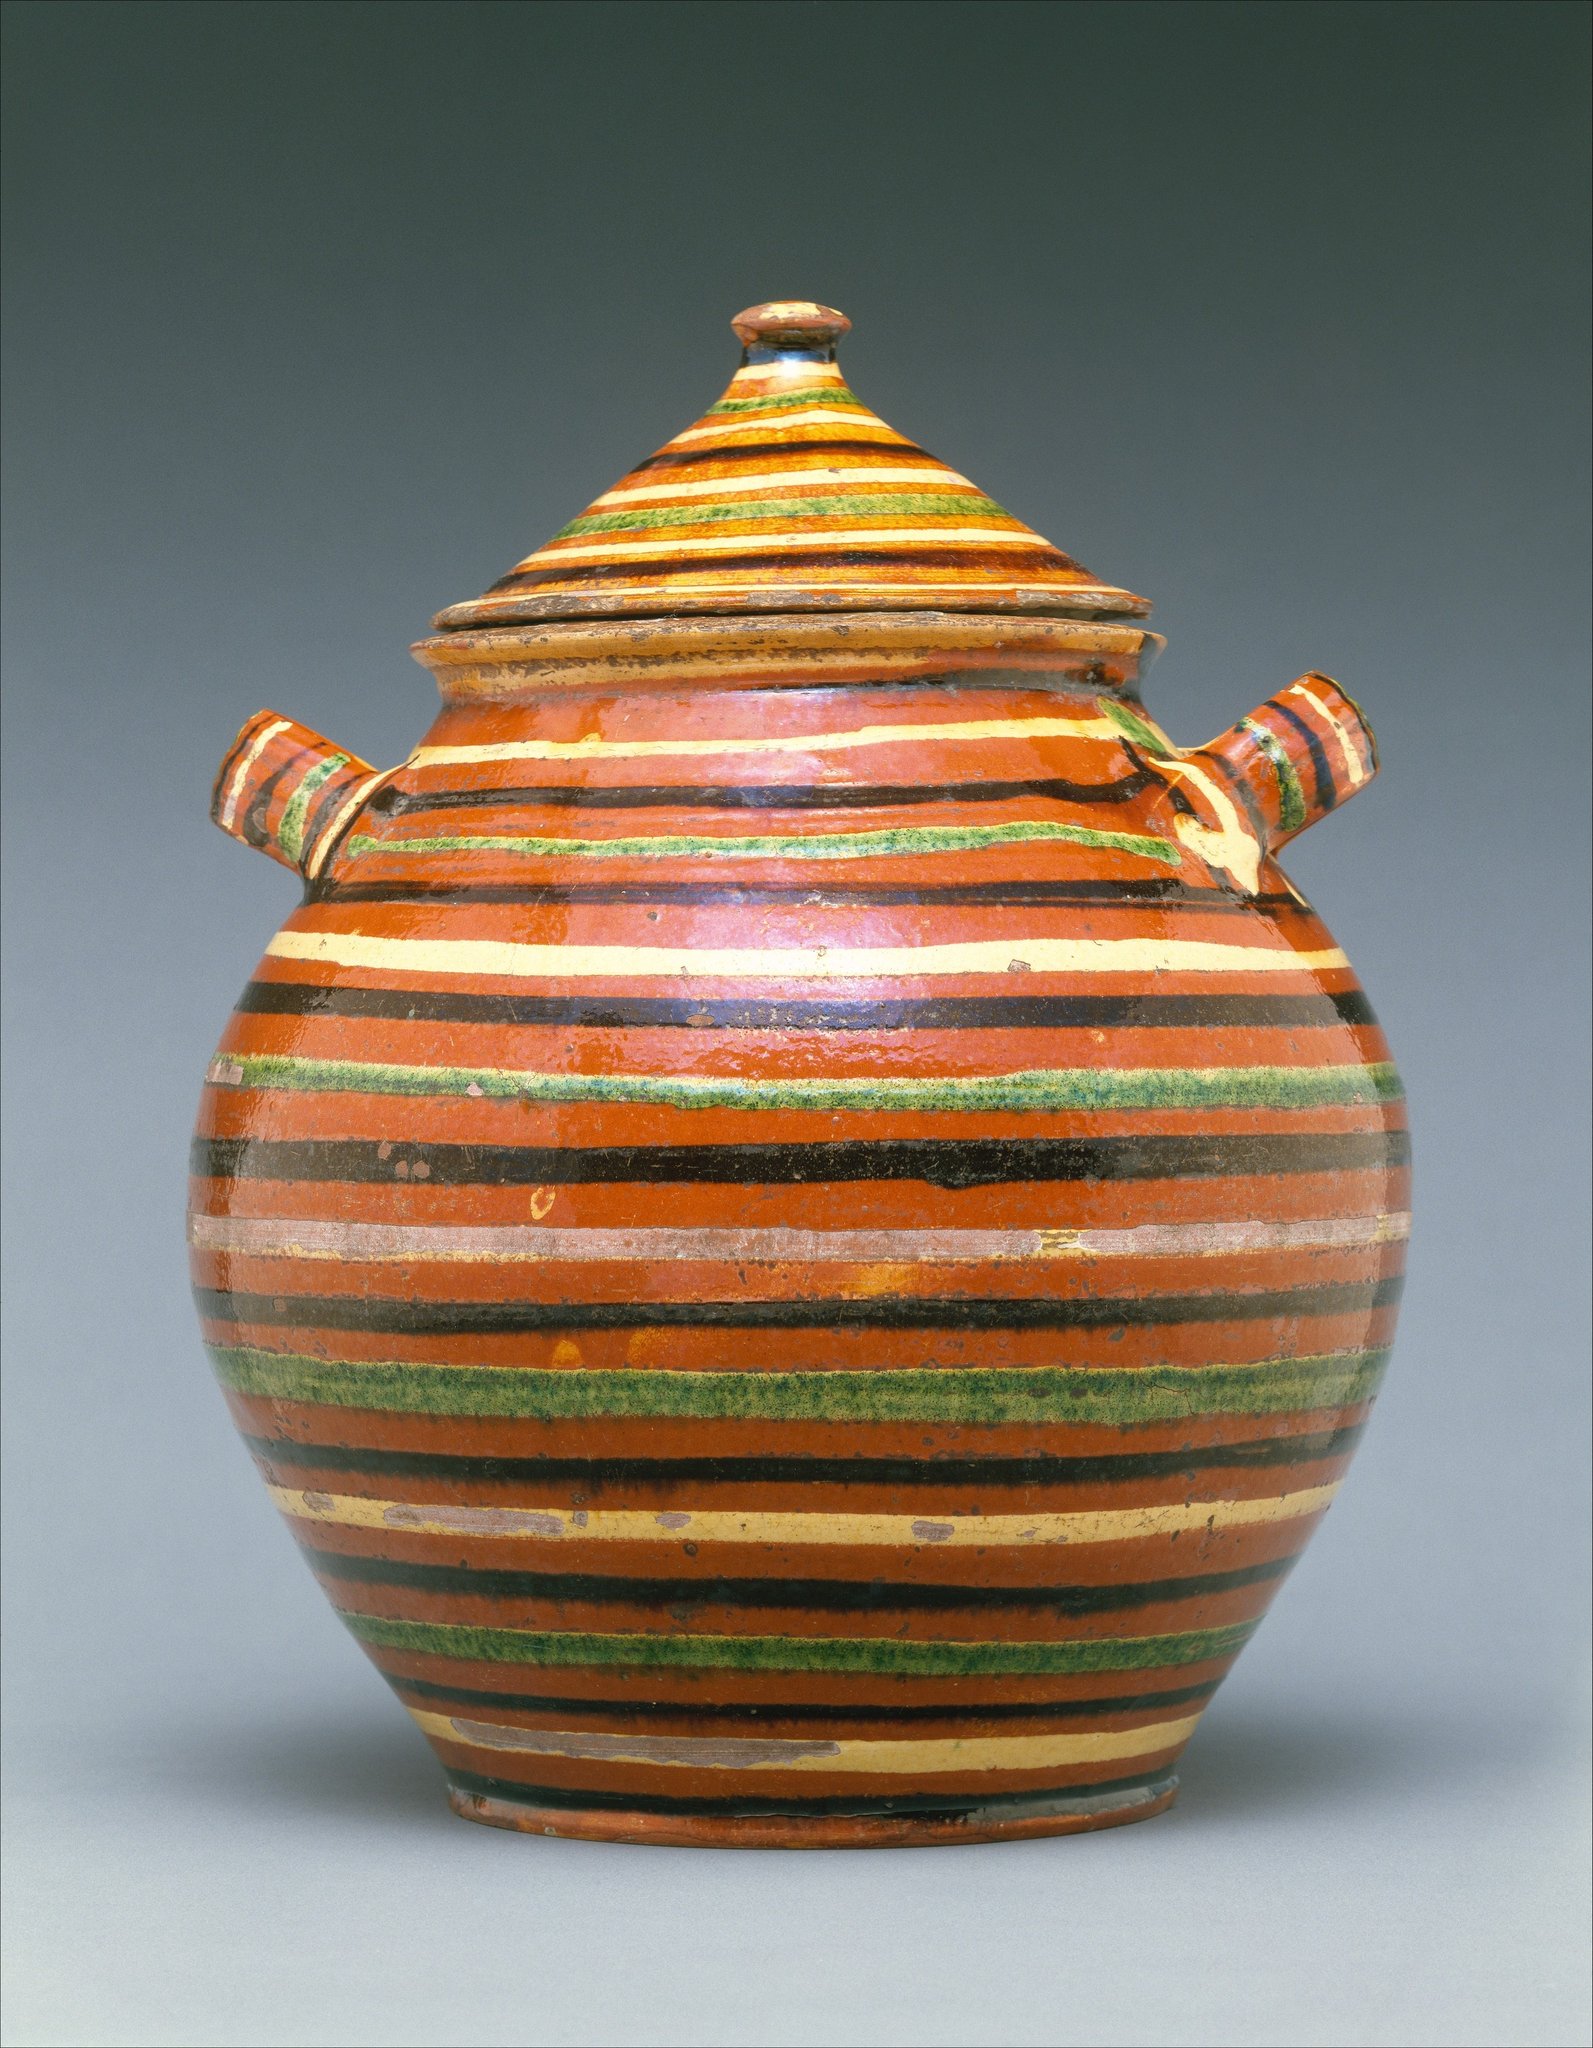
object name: sugar pot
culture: american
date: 1790-1820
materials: earthenware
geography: united states